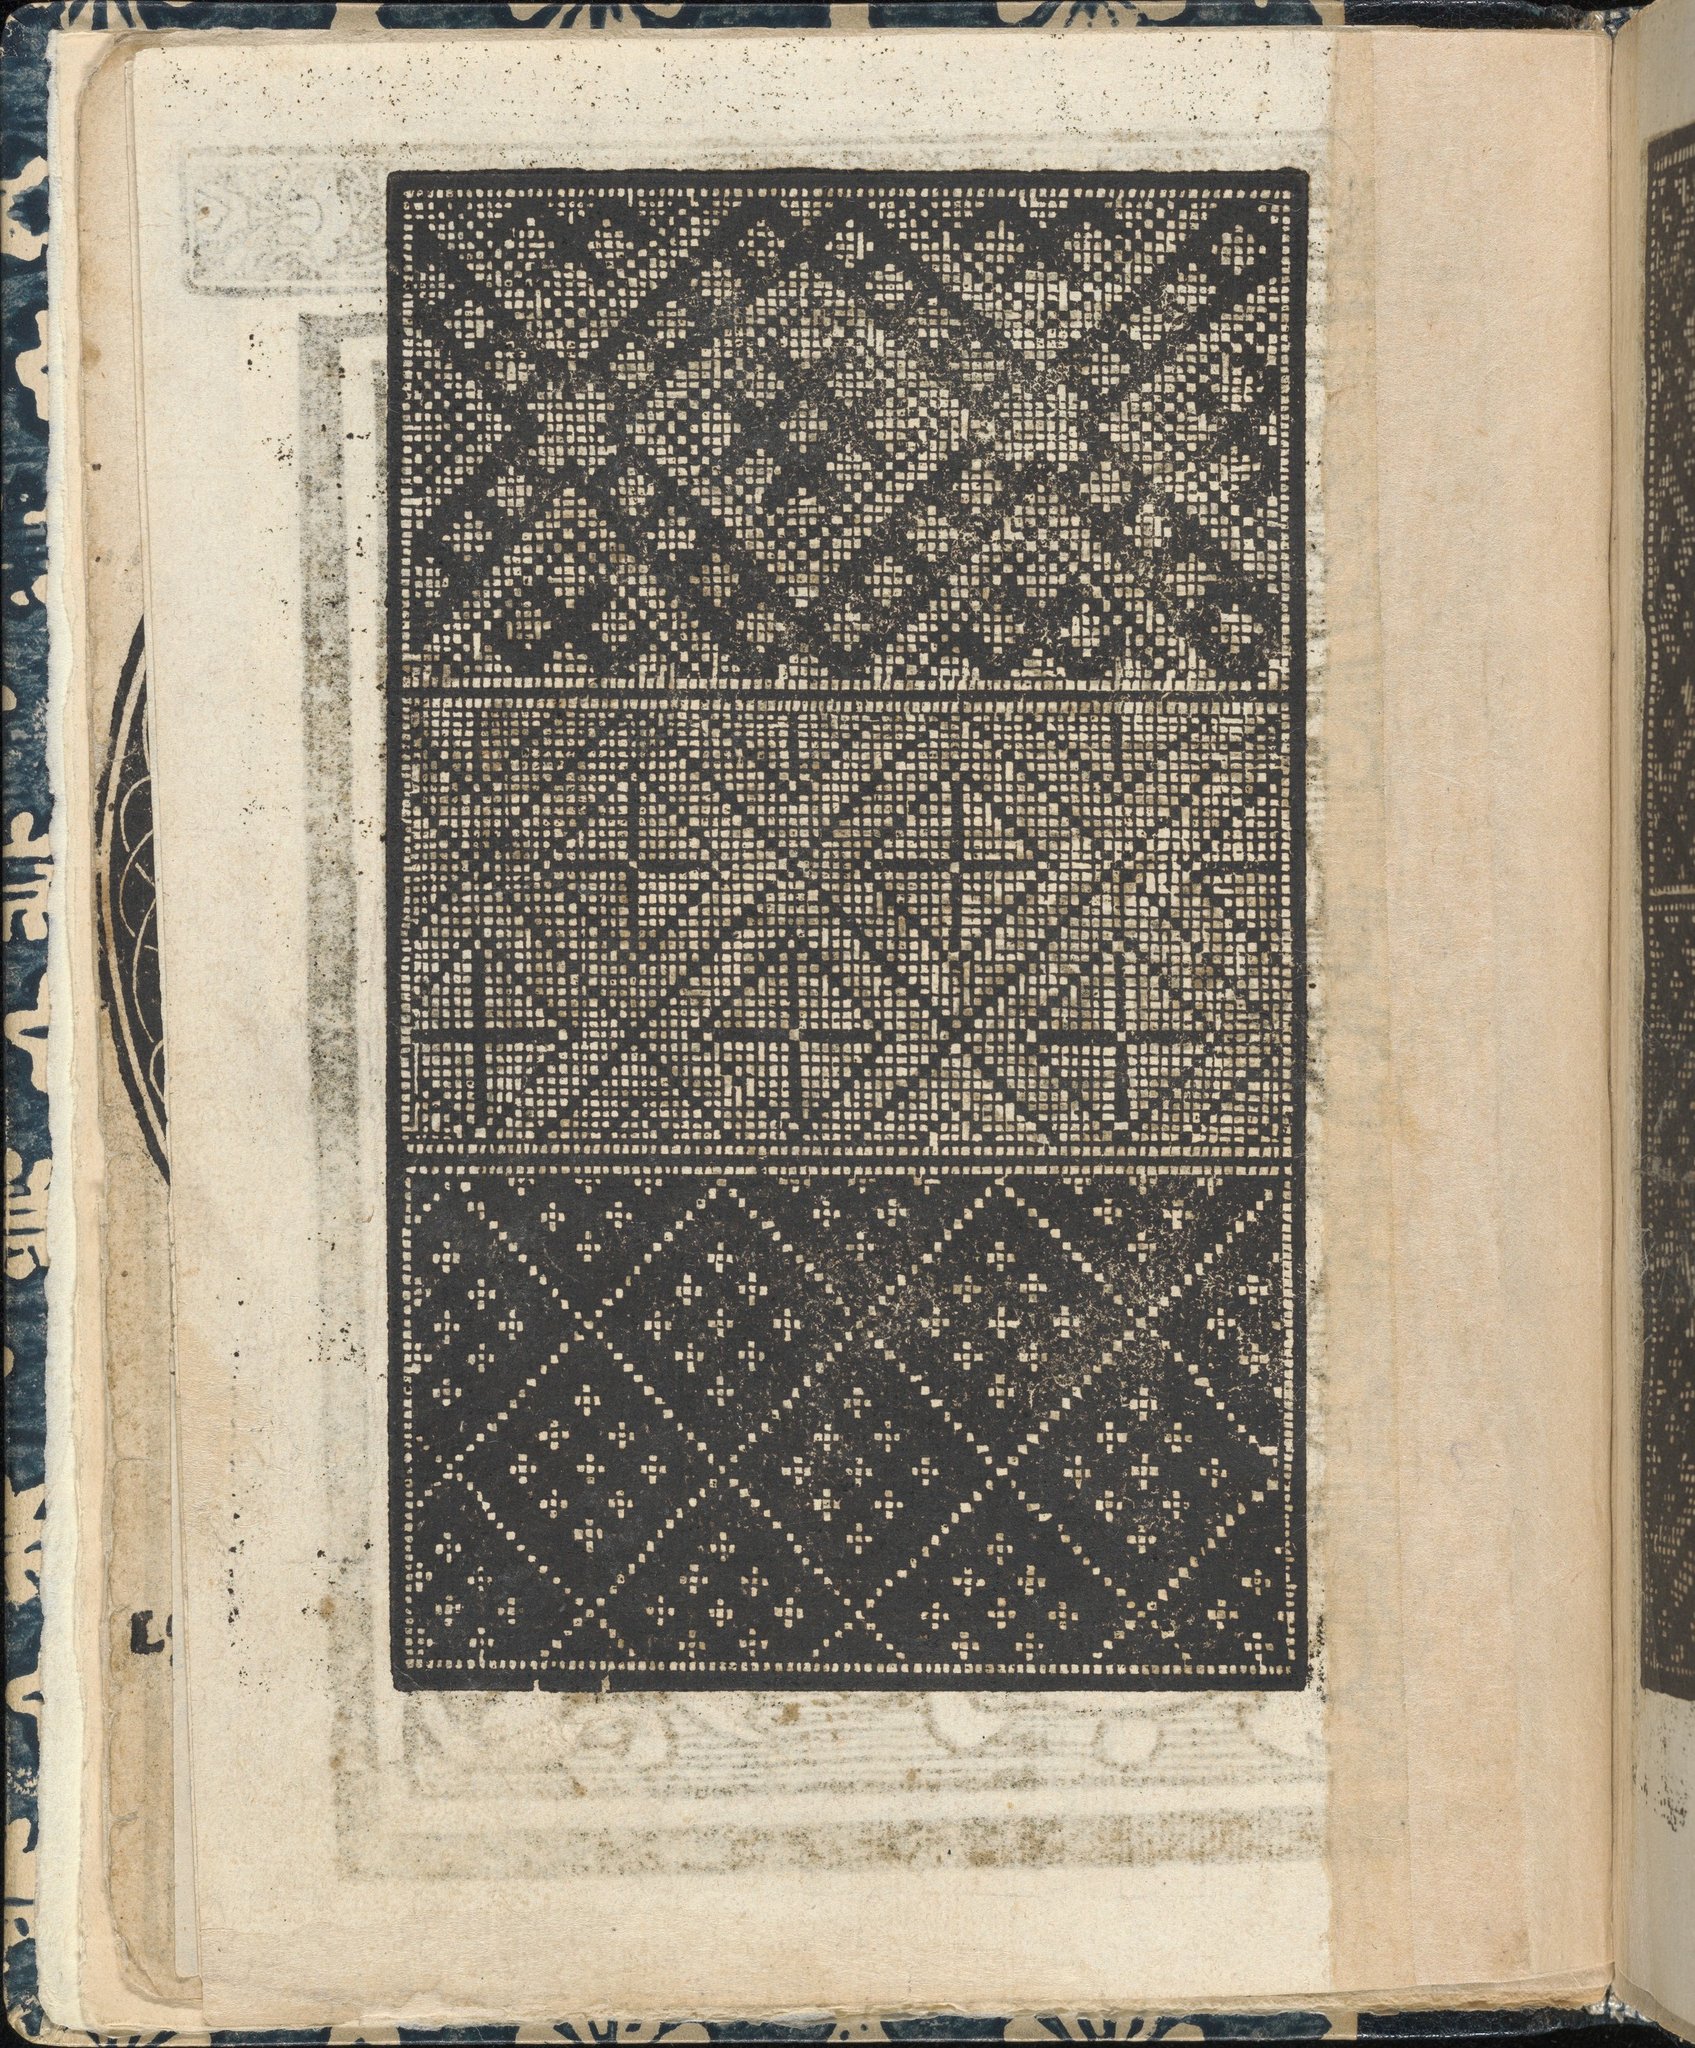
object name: book print ornament architecture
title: Essempio di recammi, page 7 (verso)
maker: giovanni antonio tagliente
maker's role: author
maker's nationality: italian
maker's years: 1465-1528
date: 1530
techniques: woodcut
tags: ornament